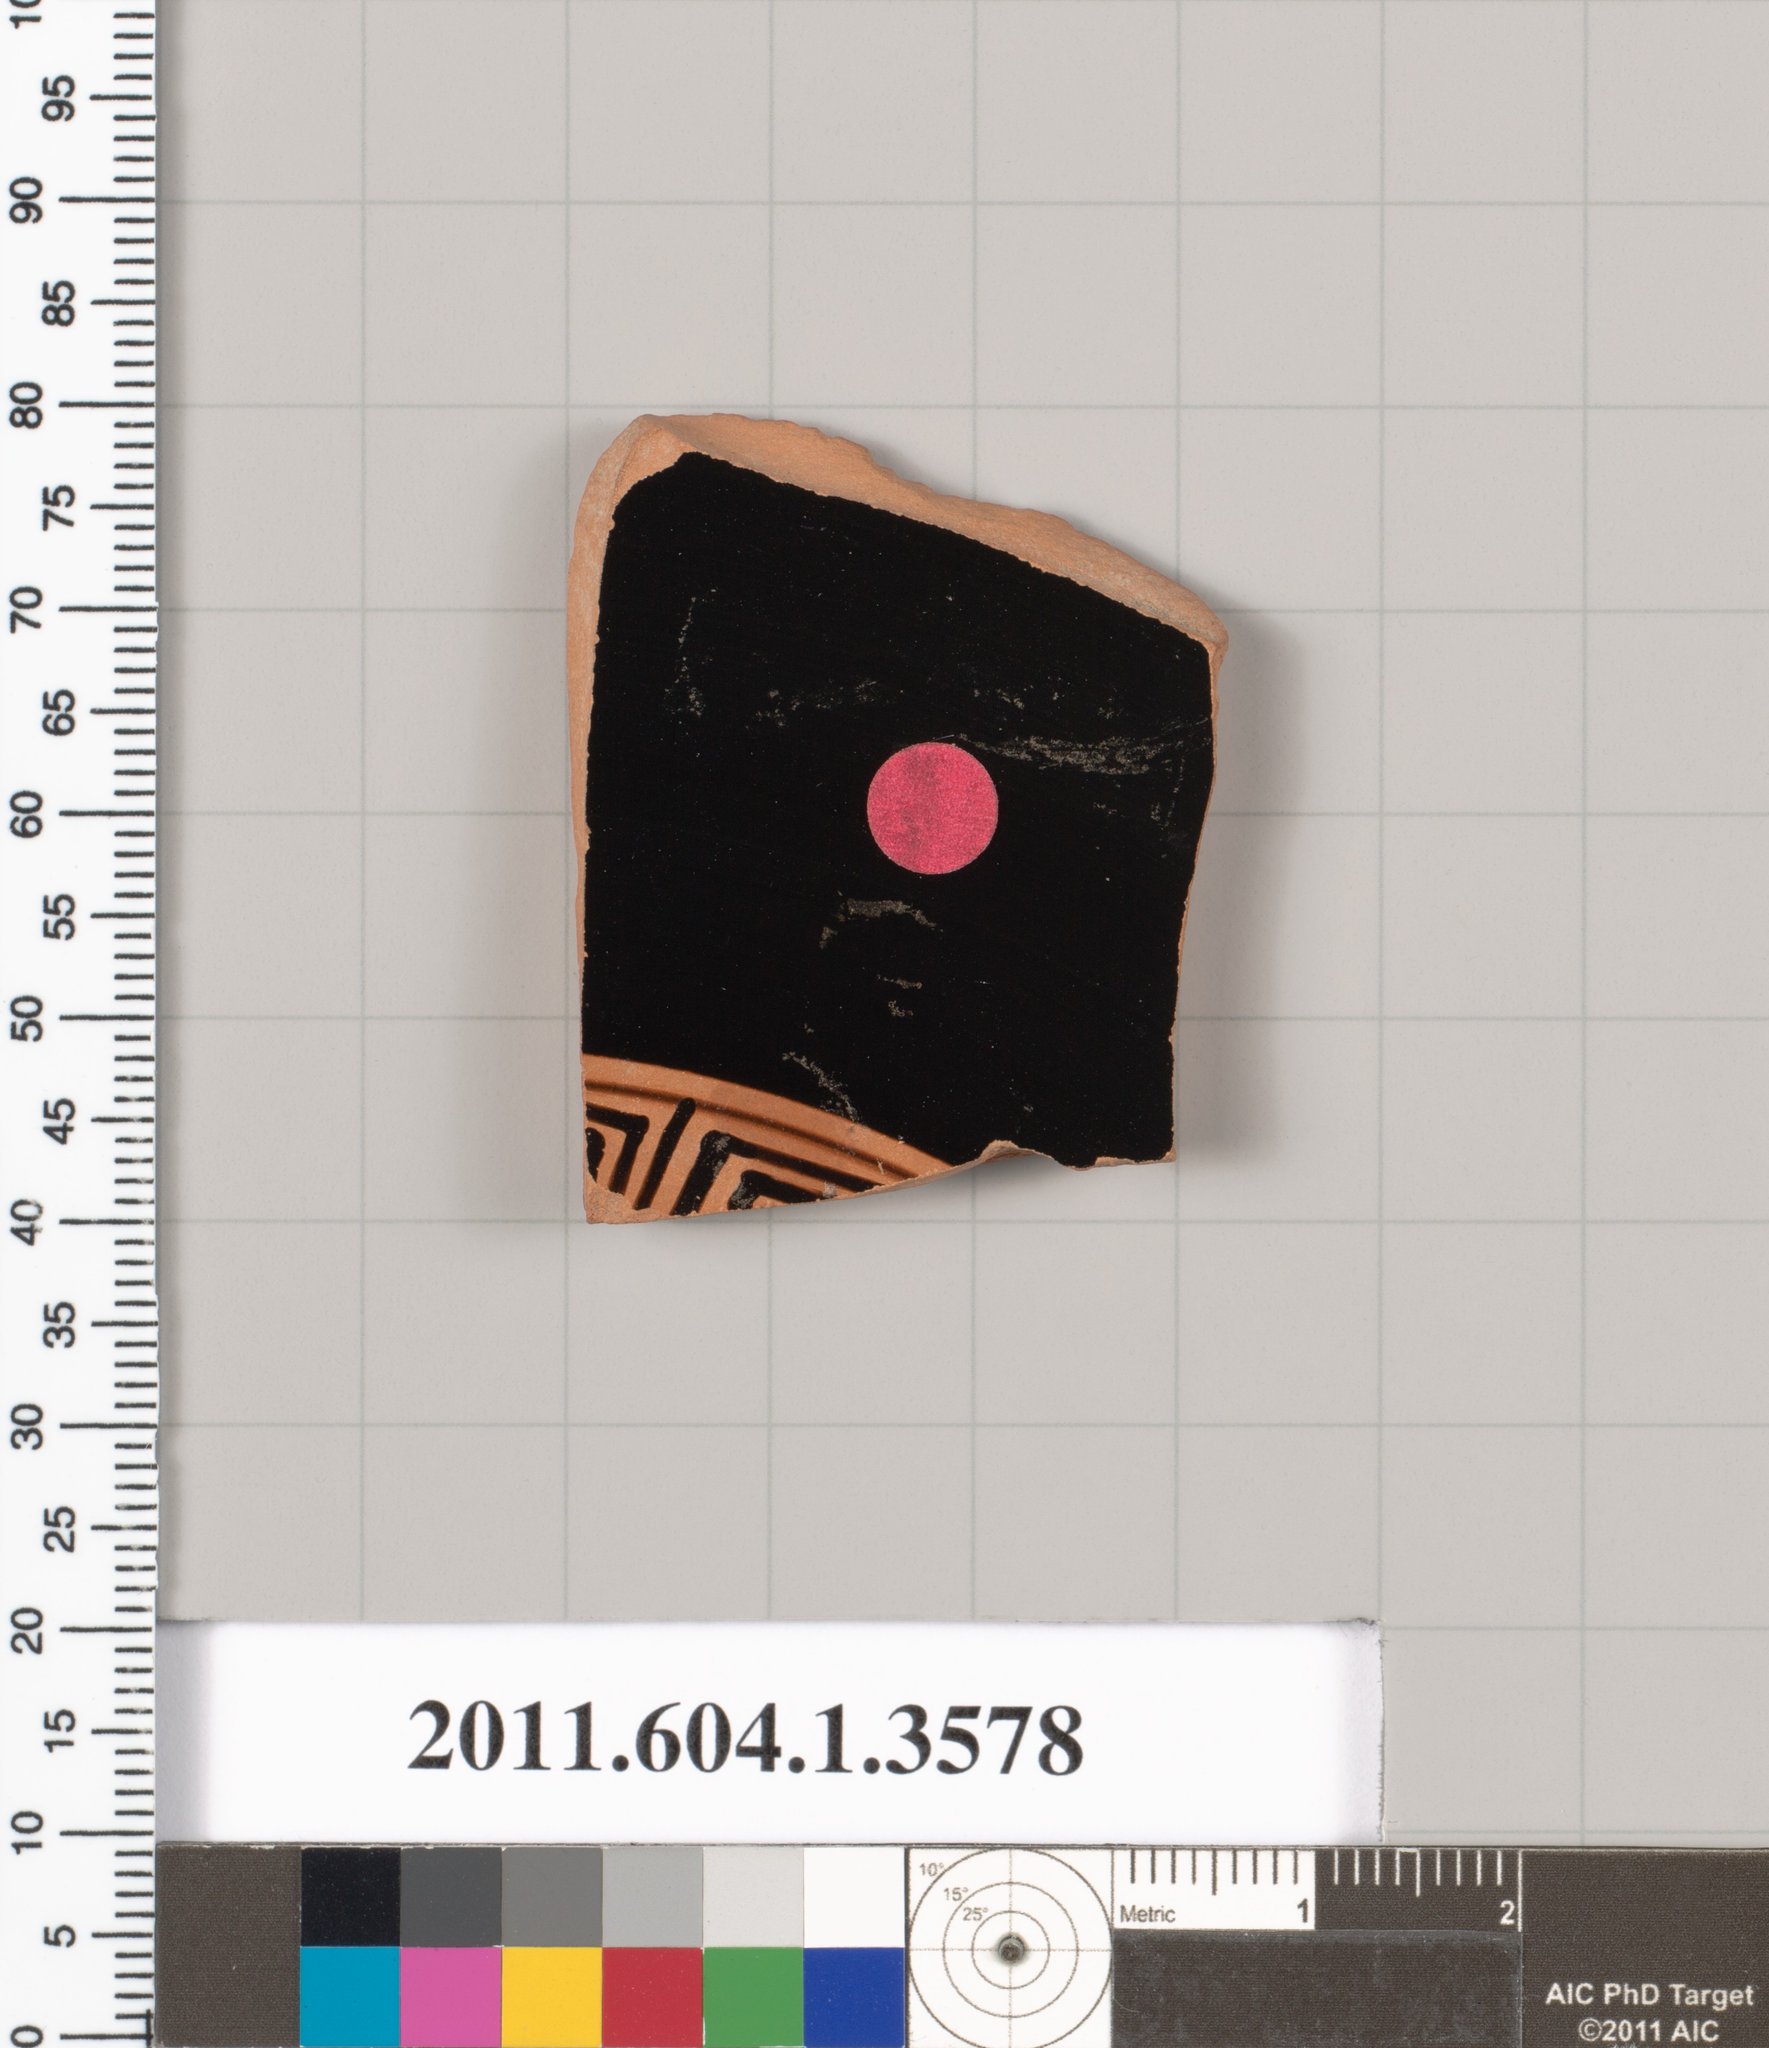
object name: kylix fragment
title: Terracotta fragment of a kylix (drinking cup)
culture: greek, attic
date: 475-451 BCE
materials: terracotta